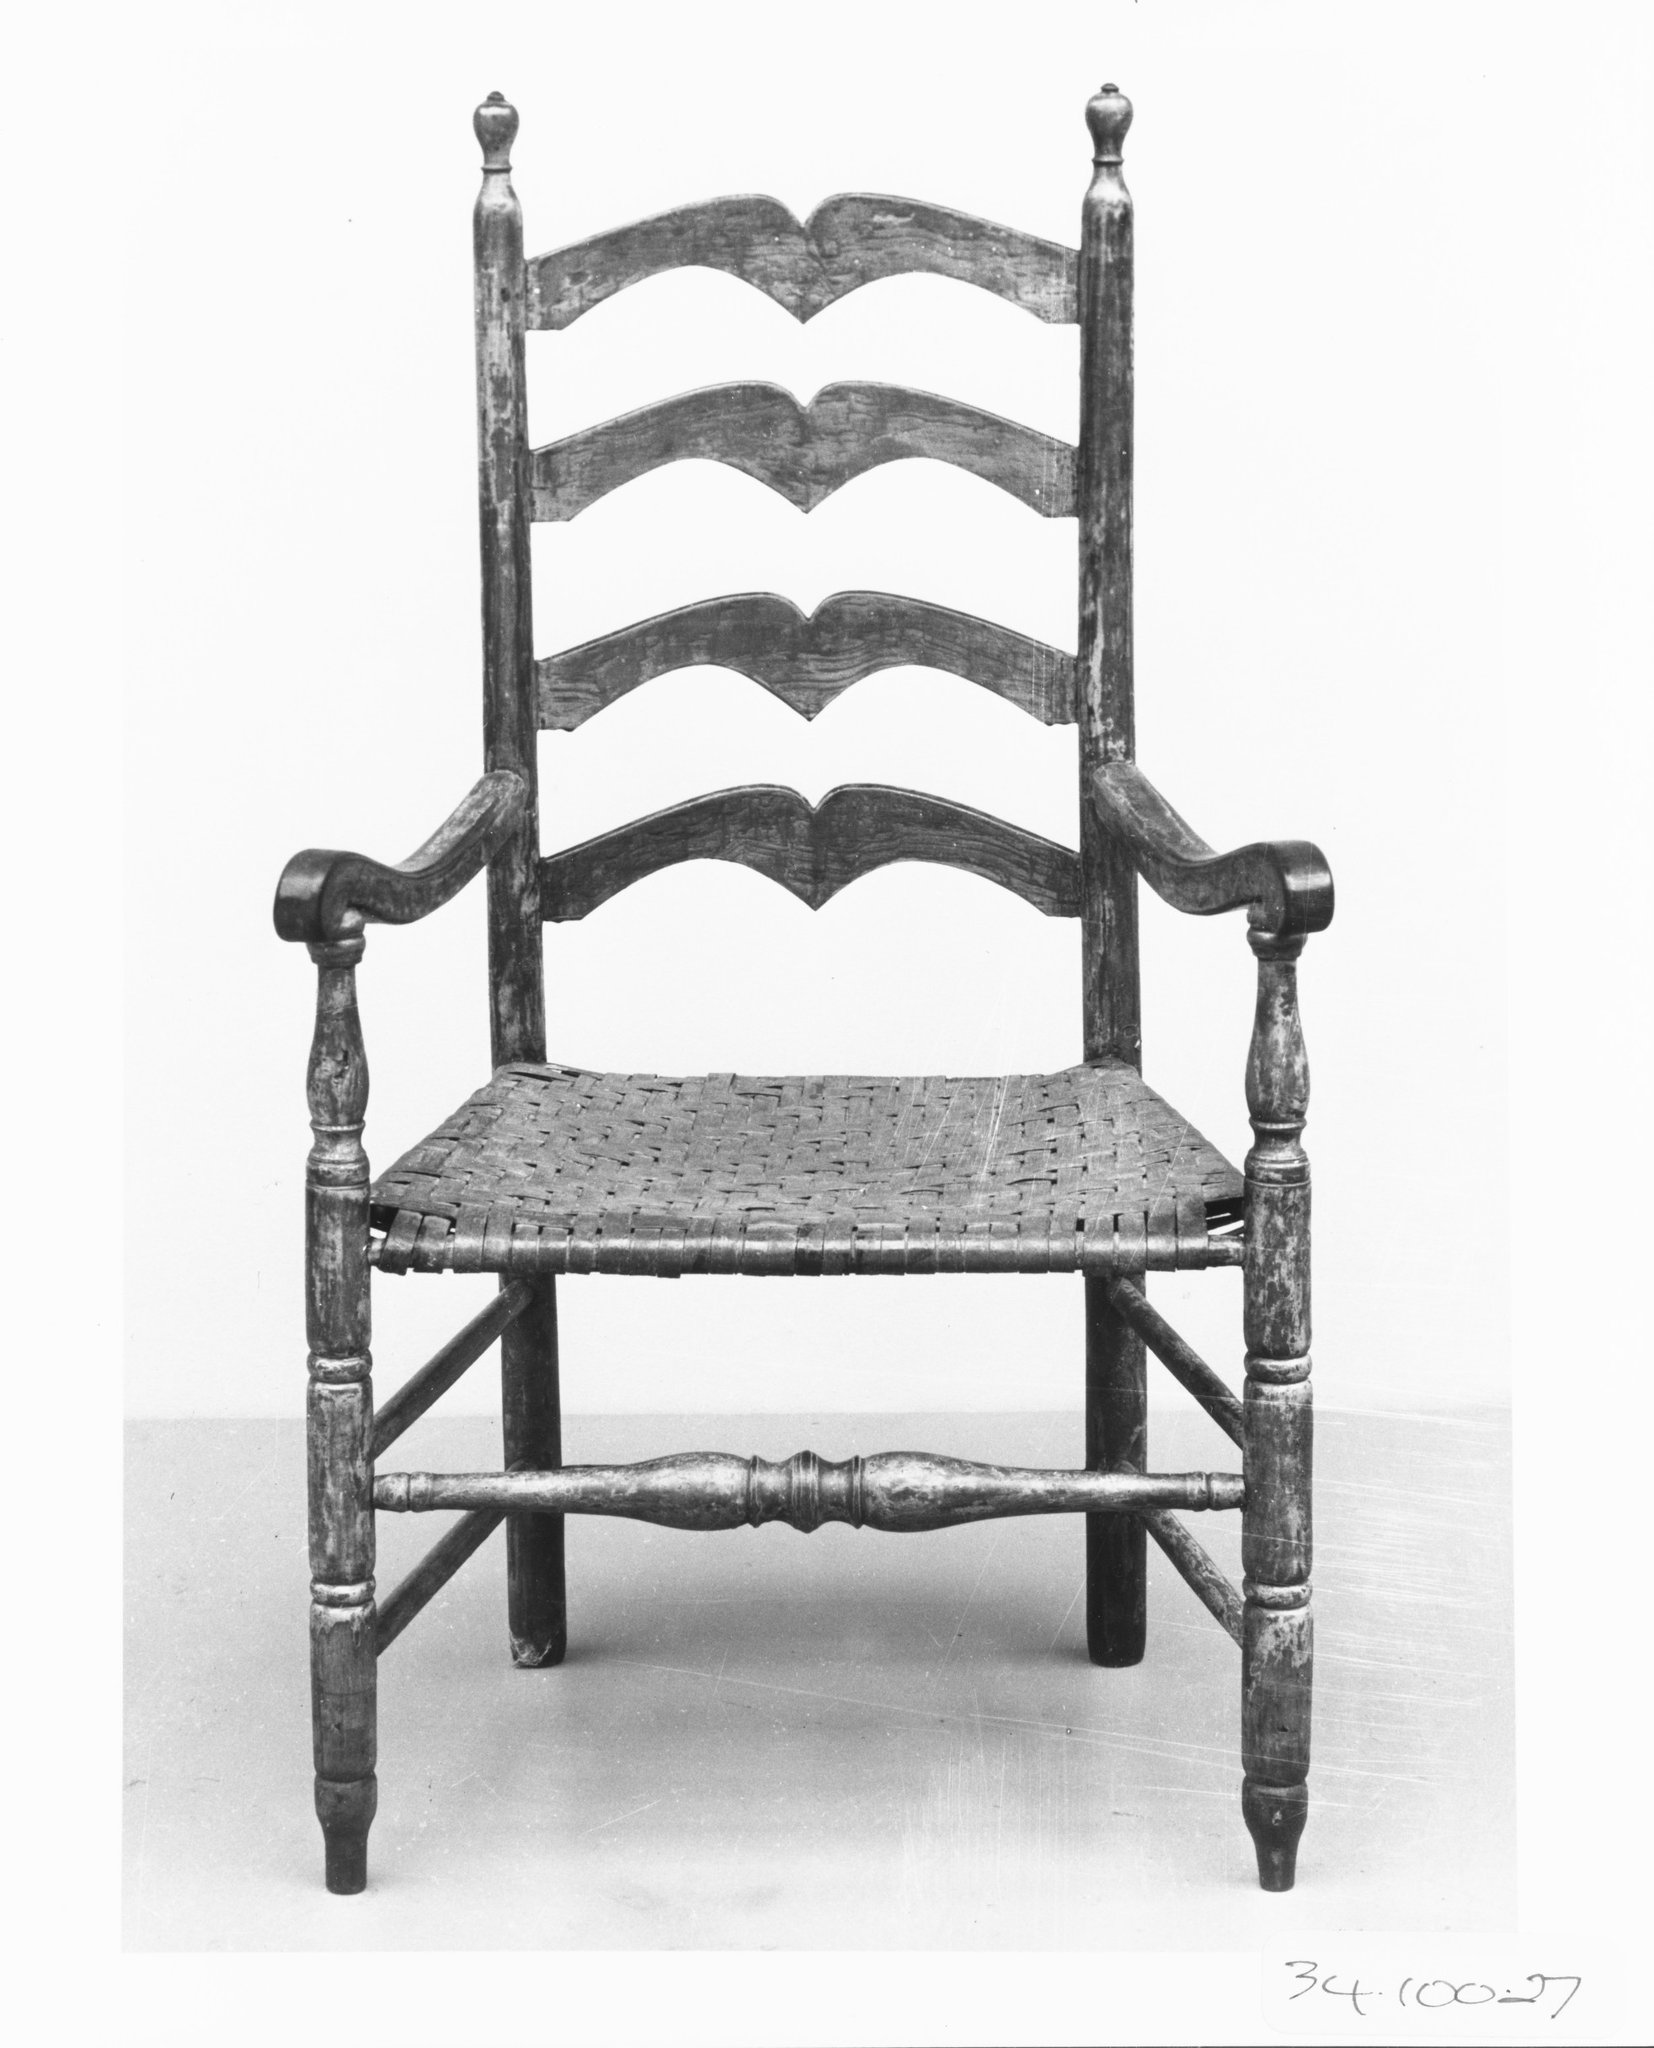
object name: armchair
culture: american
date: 1750-1780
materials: wood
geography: united states